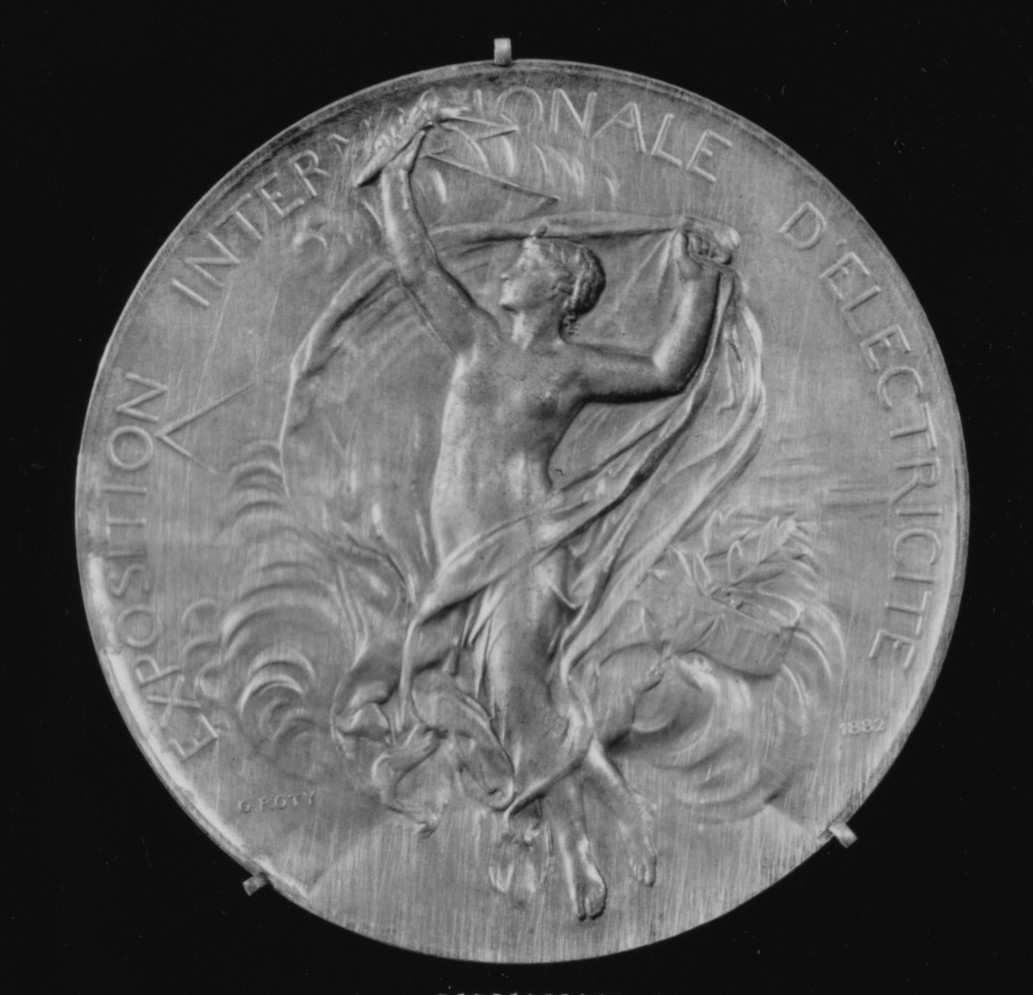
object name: medal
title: The International Exhibition of Electrical Apparatus, Paris, 1881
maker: louis-oscar roty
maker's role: artist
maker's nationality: french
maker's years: 1846-1911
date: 1881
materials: bronze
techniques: silvered, struck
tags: female nudes